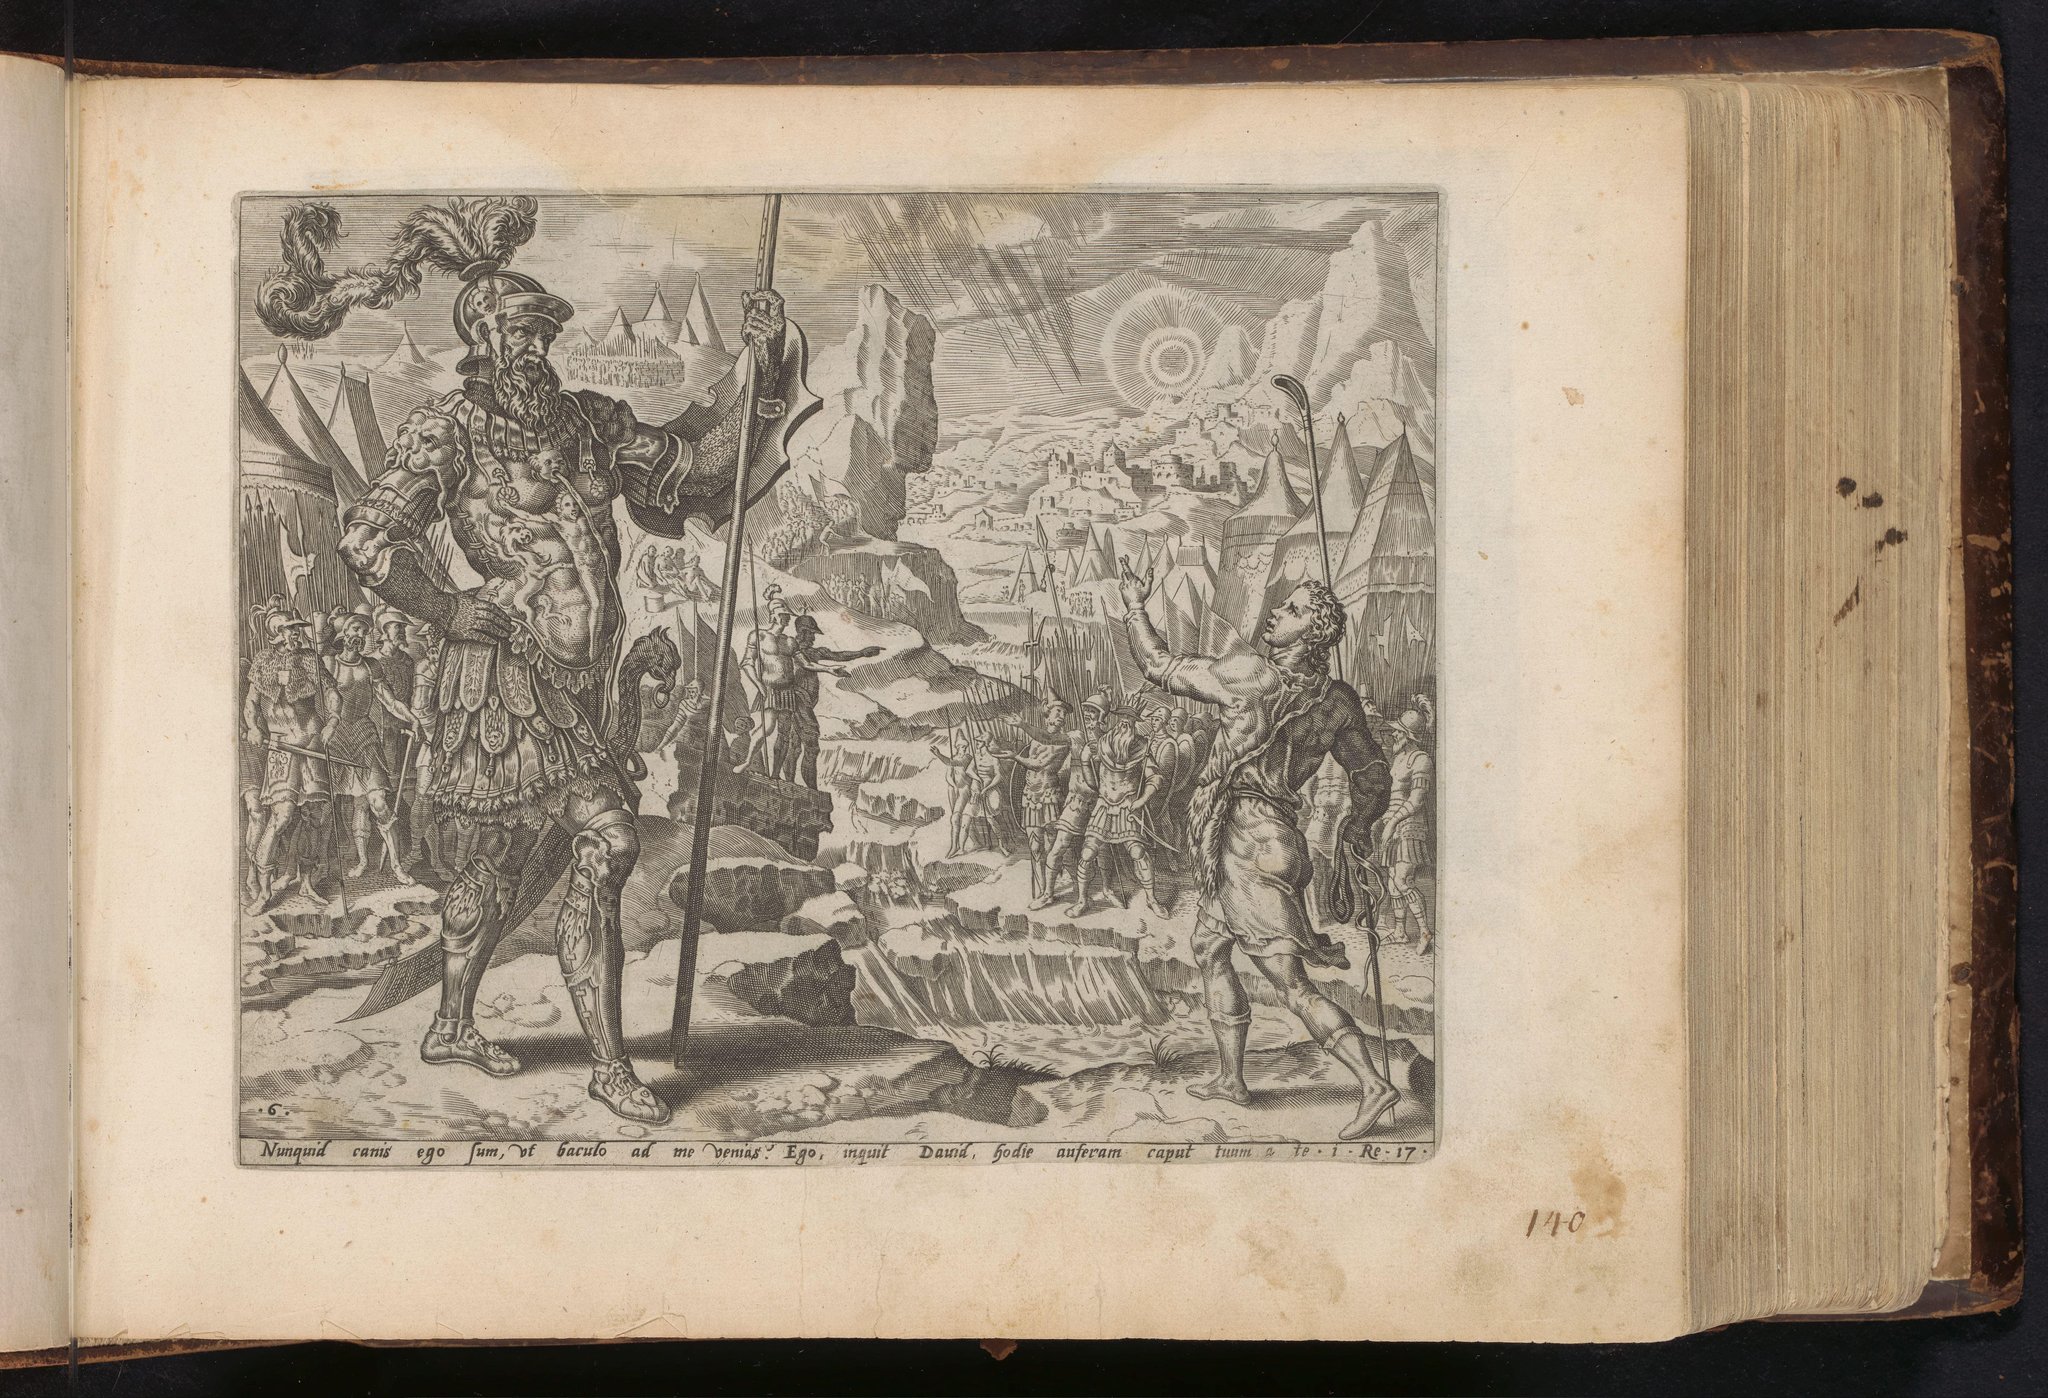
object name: print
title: Van Saul, David, en Goliath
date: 1554-1558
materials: paper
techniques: engraving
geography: amsterdam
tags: david speaks with goliath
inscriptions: number: ‘140’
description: David staat in eenvoudige kleding voor de Filistijn Goliat. In zijn rechterhand heeft hij zijn herdersstaf en de slinger. Ze zijn in gesprek met elkaar, terwijl beide legers toekijken. Onder de voorstelling een verwijzing in het Latijn naar de Bijbeltekst in 1 Sam. 17. Deze prent maakt deel uit van een album.